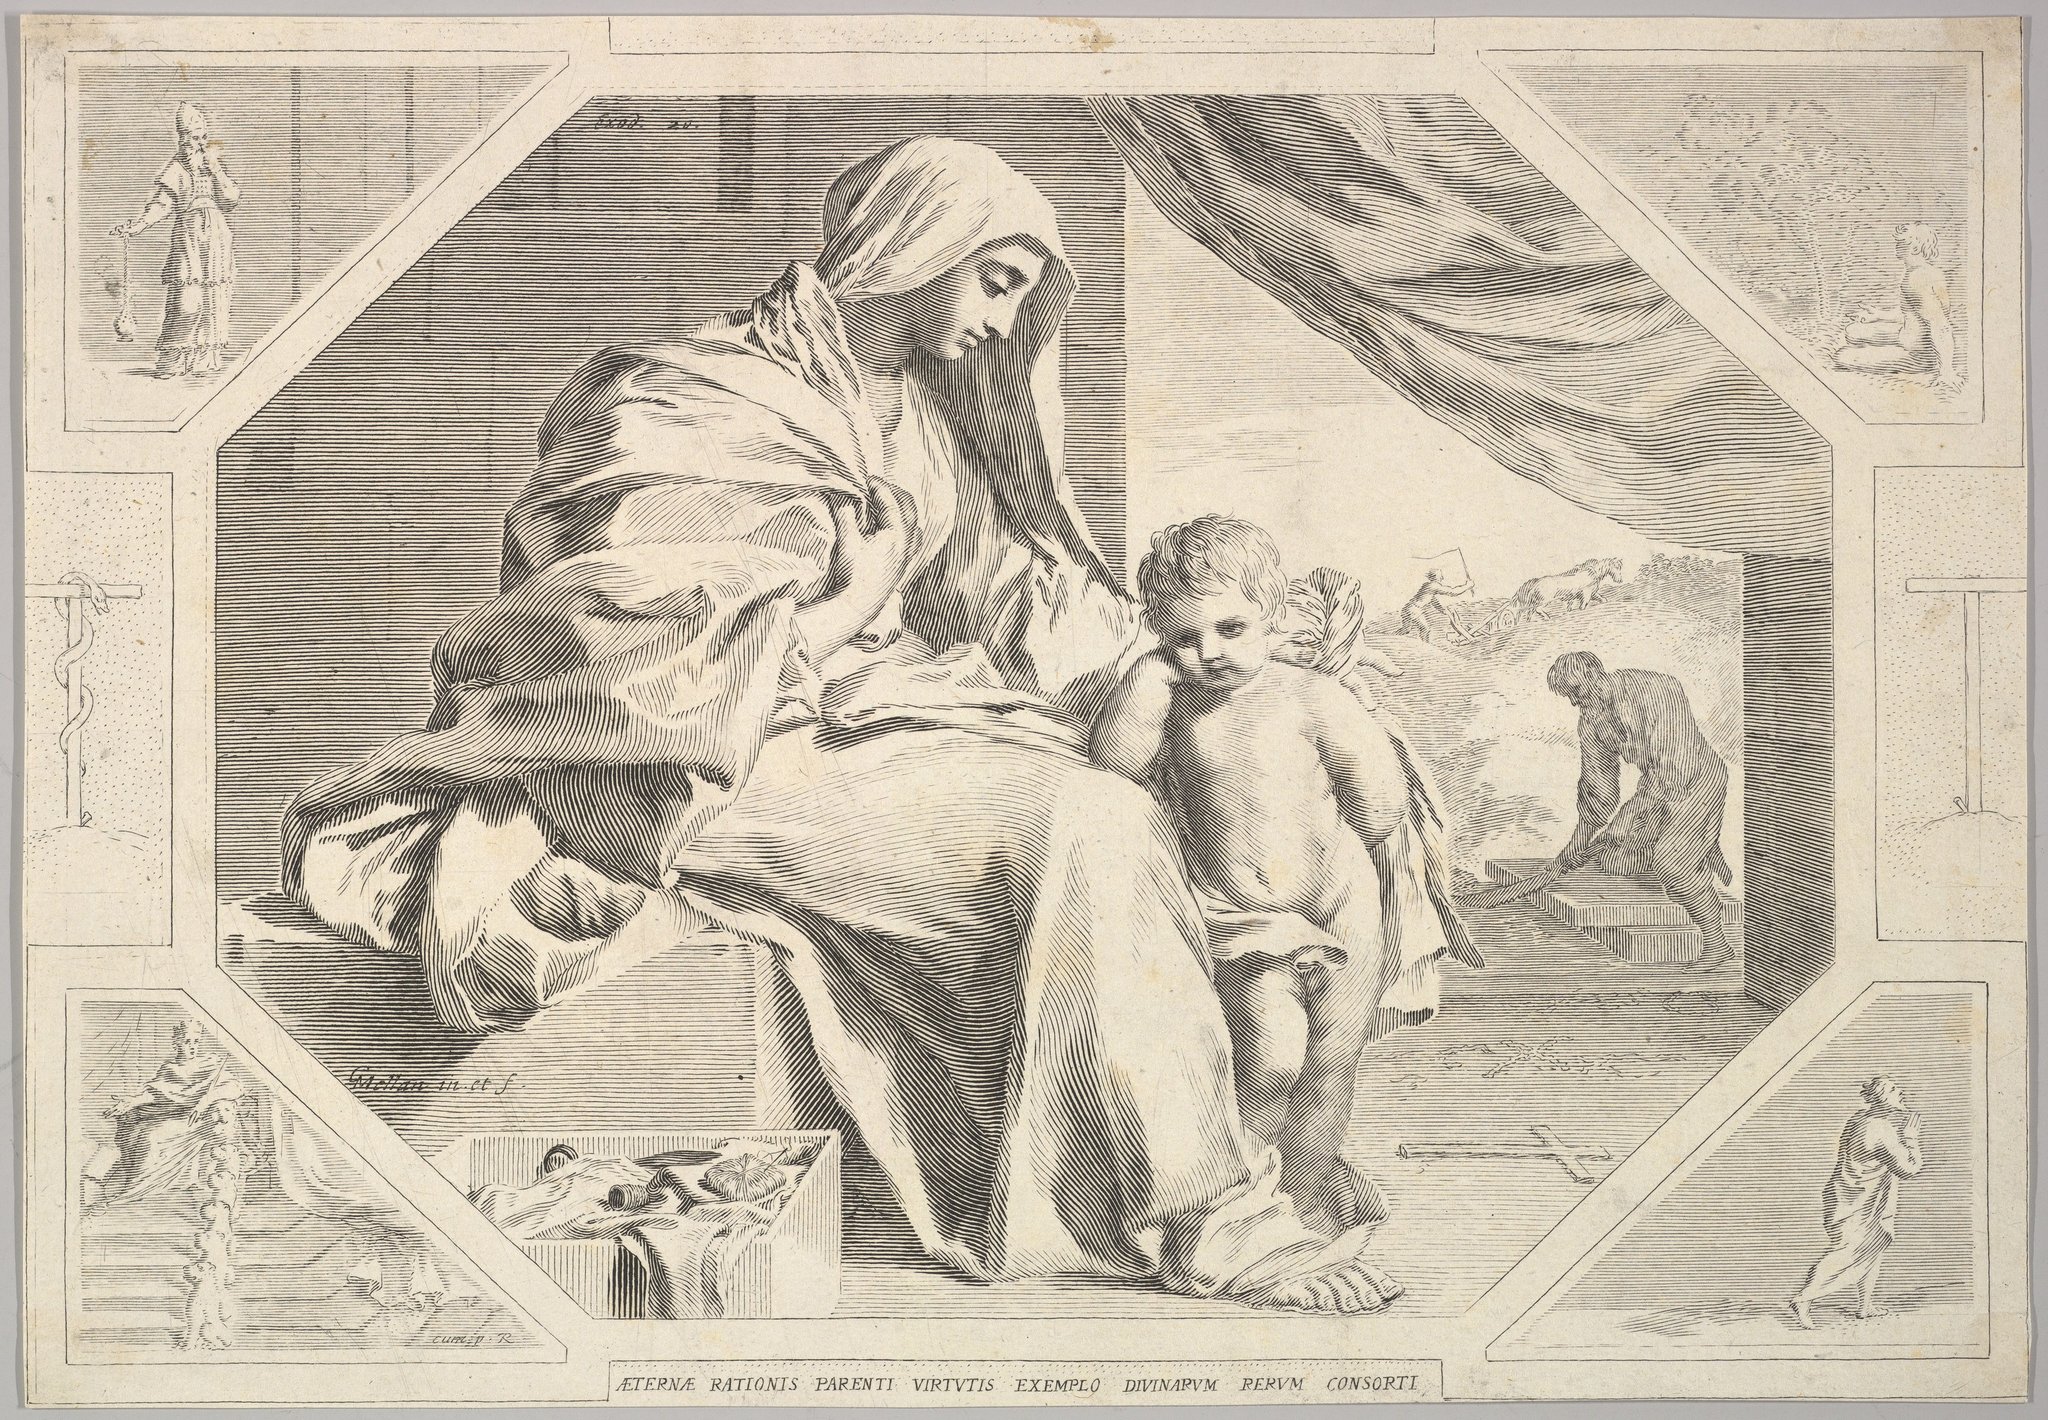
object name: print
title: Holy Family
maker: claude mellan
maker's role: artist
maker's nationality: french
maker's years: 1598-1688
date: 1598-1688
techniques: engraving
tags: holy family